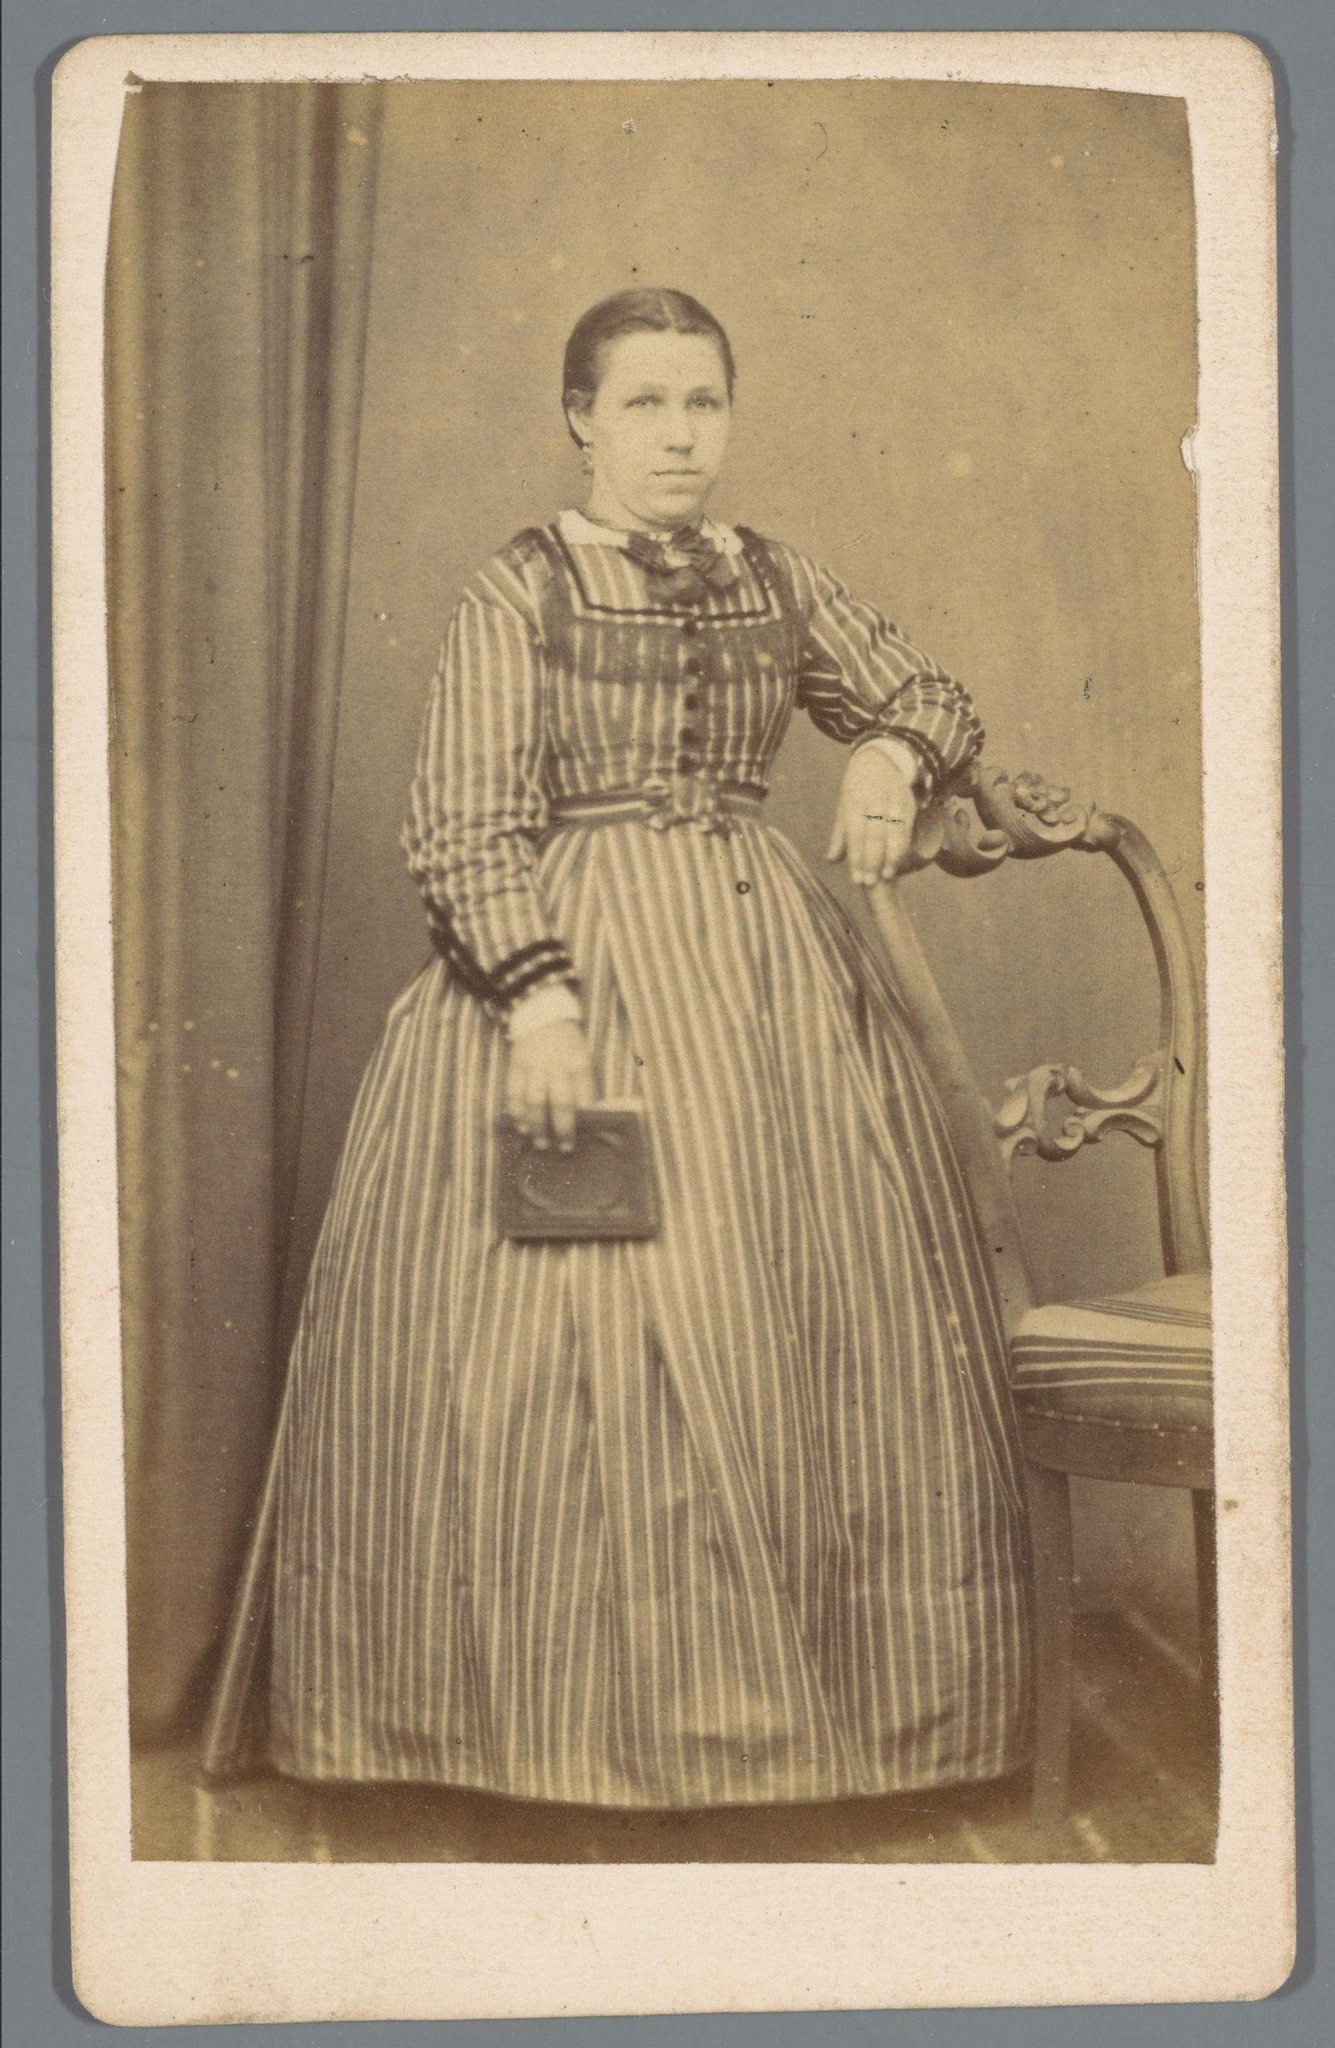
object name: carte de visite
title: Portret van een onbekende jonge vrouw met een boek bij een stoel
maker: bernardus petrus rabels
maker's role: fotograaf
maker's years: 1824-1906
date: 1870-1893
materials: cardboard, paper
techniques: albumen print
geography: amsterdam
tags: adolescent, young woman, maiden, anonymous historical person portrayed, amsterdam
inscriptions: inscription: ‘Photographisch Atelier/ van/ B.P. Rabels/ Prinsengracht bij de Leliestraat M.M.524./ Amsterdam.’